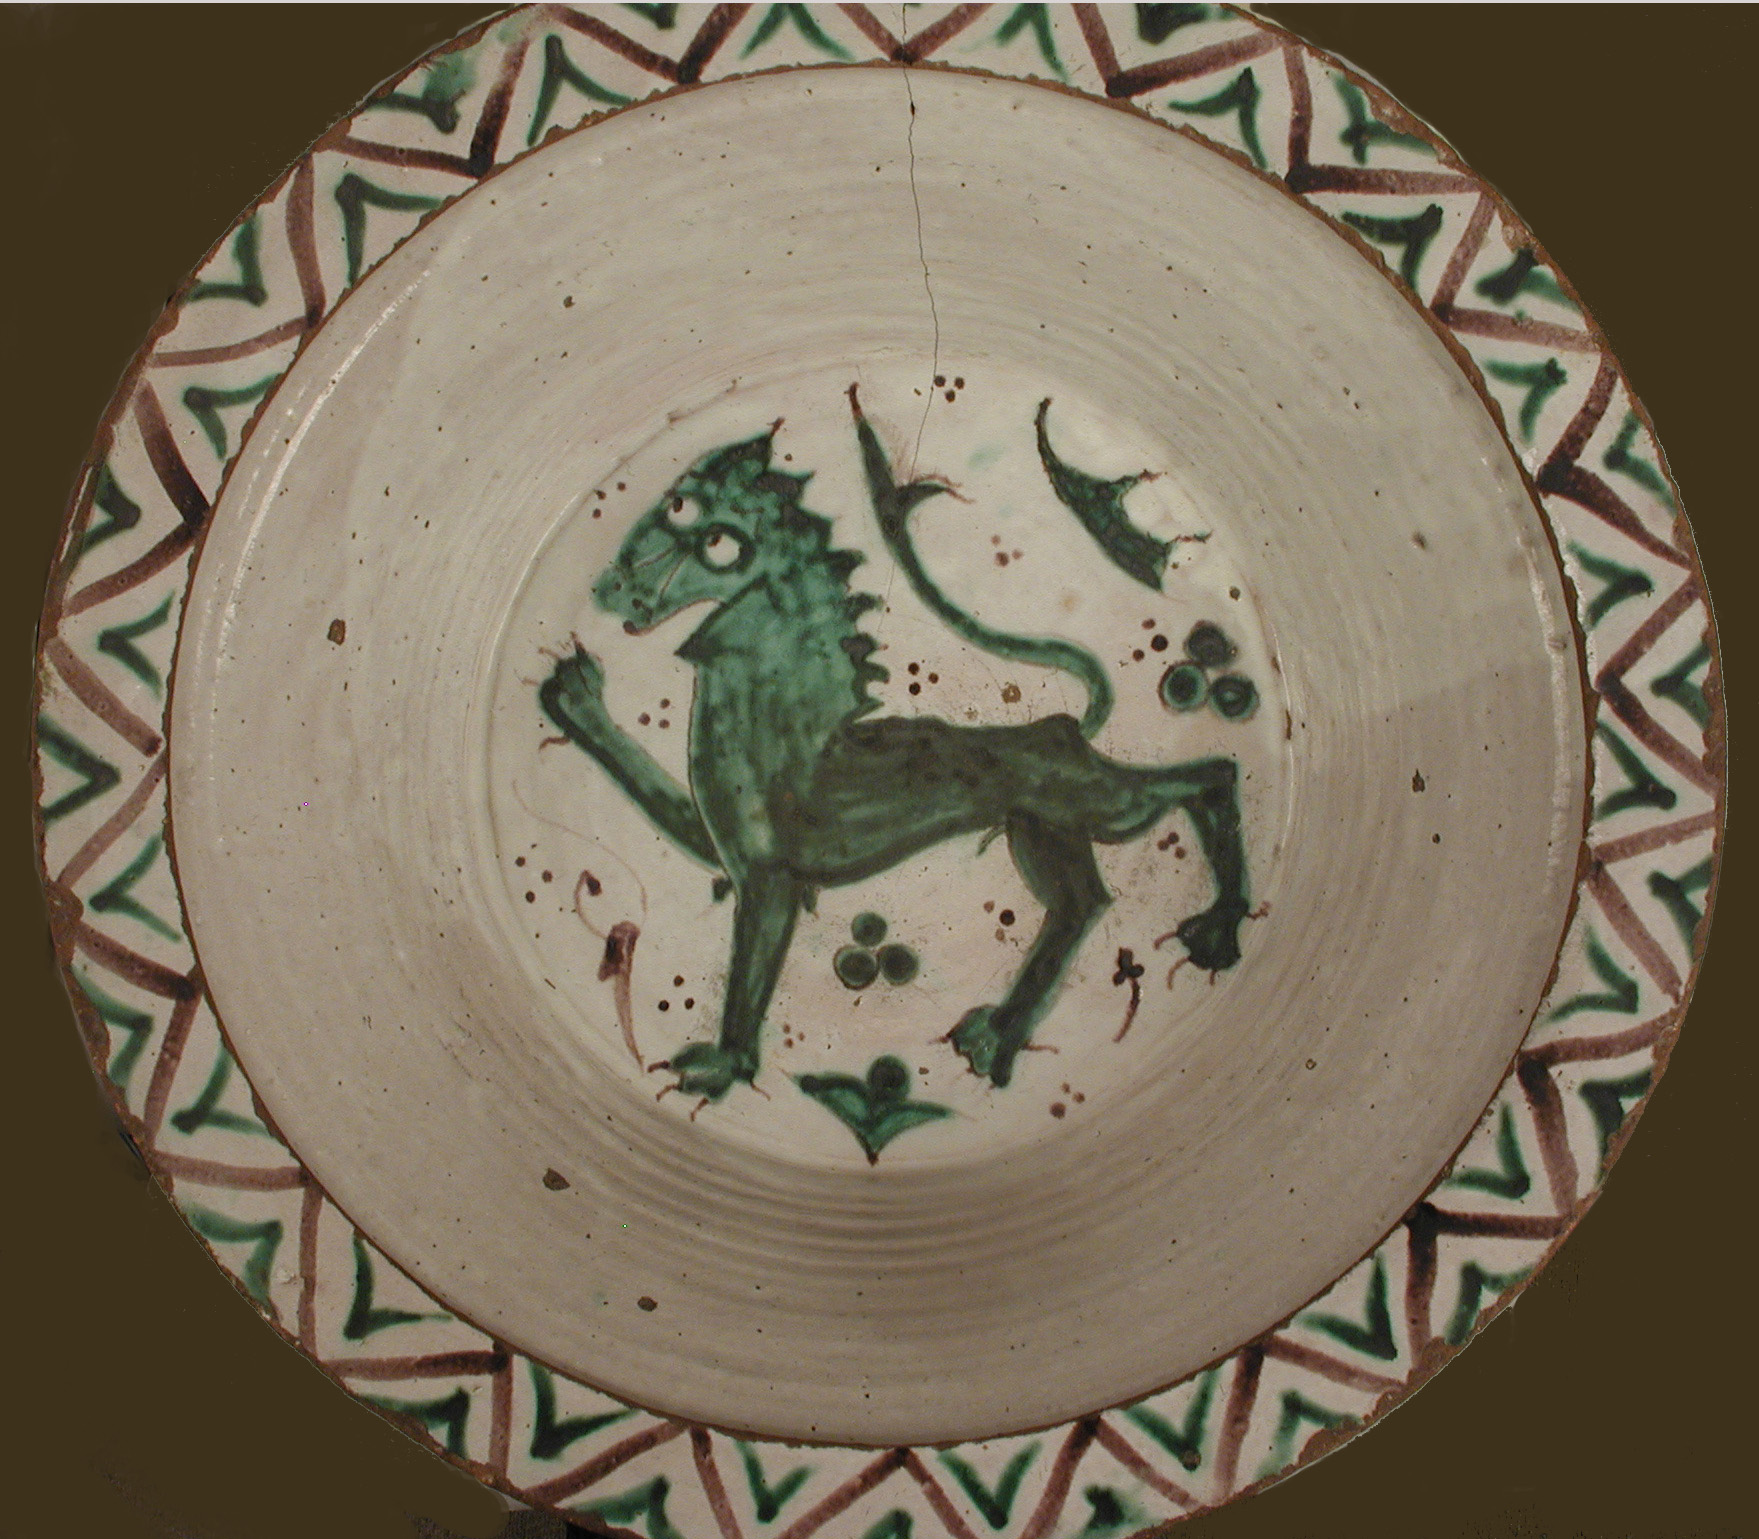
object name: bowl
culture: spanish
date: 1501-1600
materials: earthenware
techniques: glazing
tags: lions